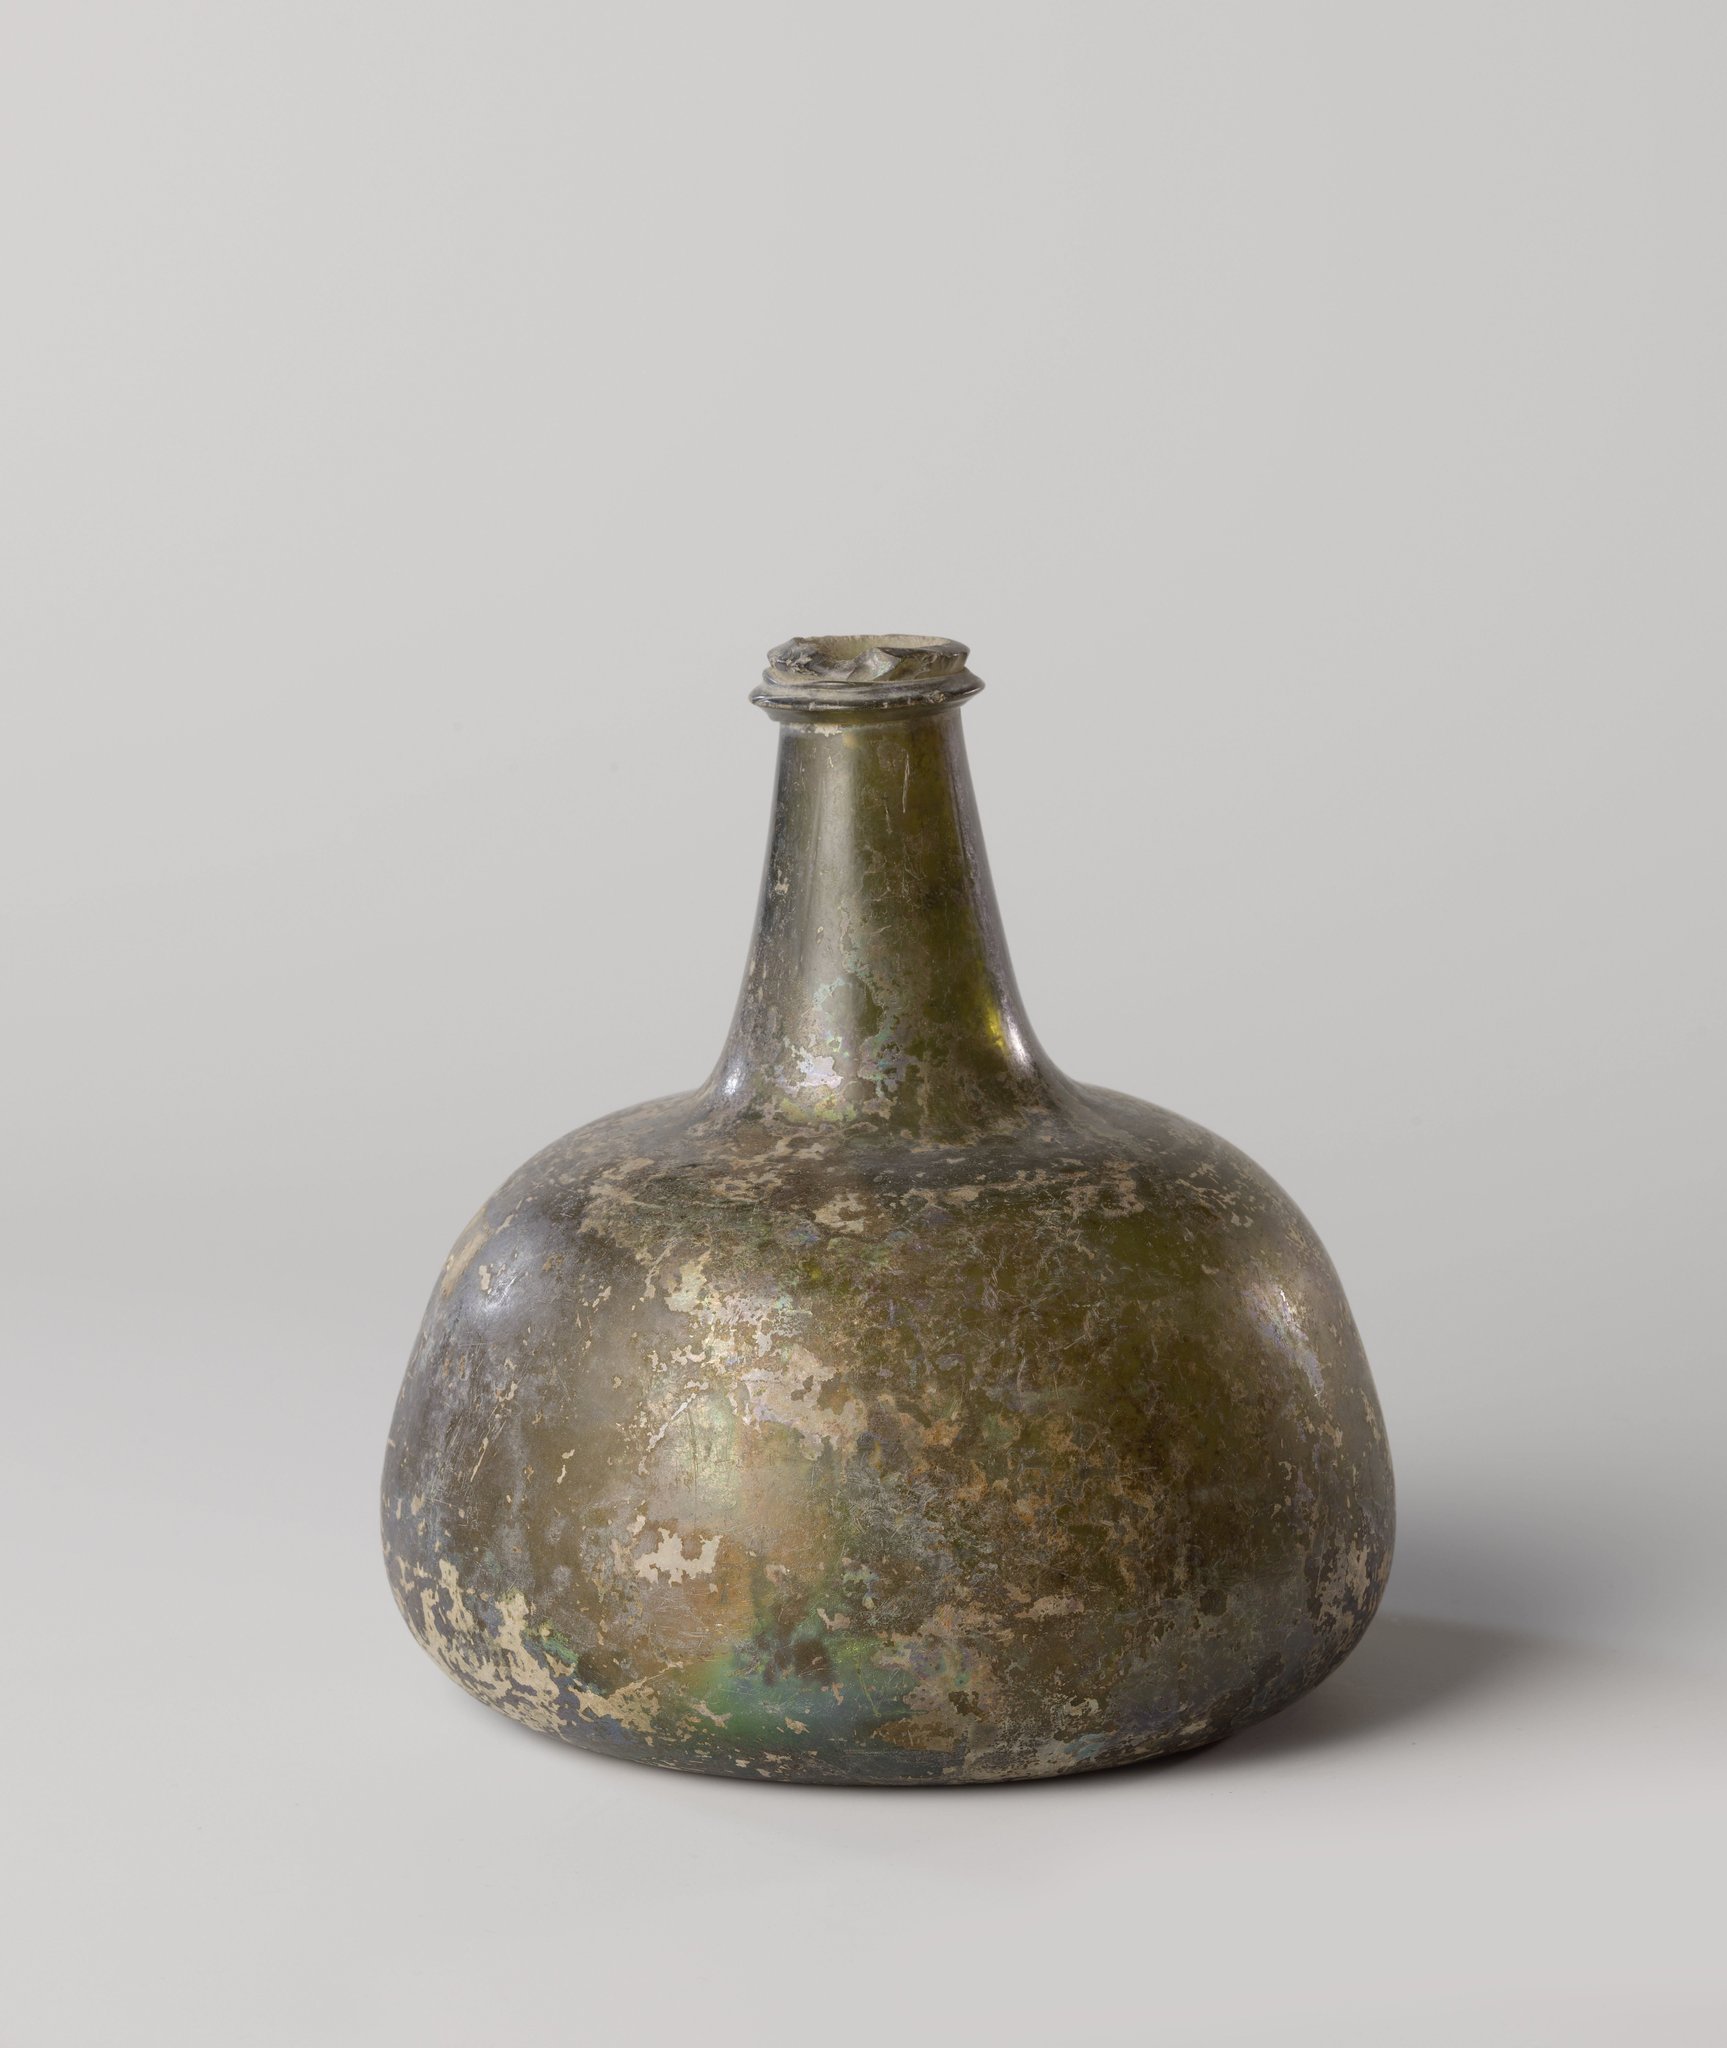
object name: bottle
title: Fles met bolvormig lichaam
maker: Anonymous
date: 1725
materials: glass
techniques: glassblowing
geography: northwest europe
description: Diep ingestoken ziel, zich versmallend lichaam via afgeronde schouders overgaand in een sterk toelopende hals met een hoog geplaatste ring. Glas zeer irriserend.